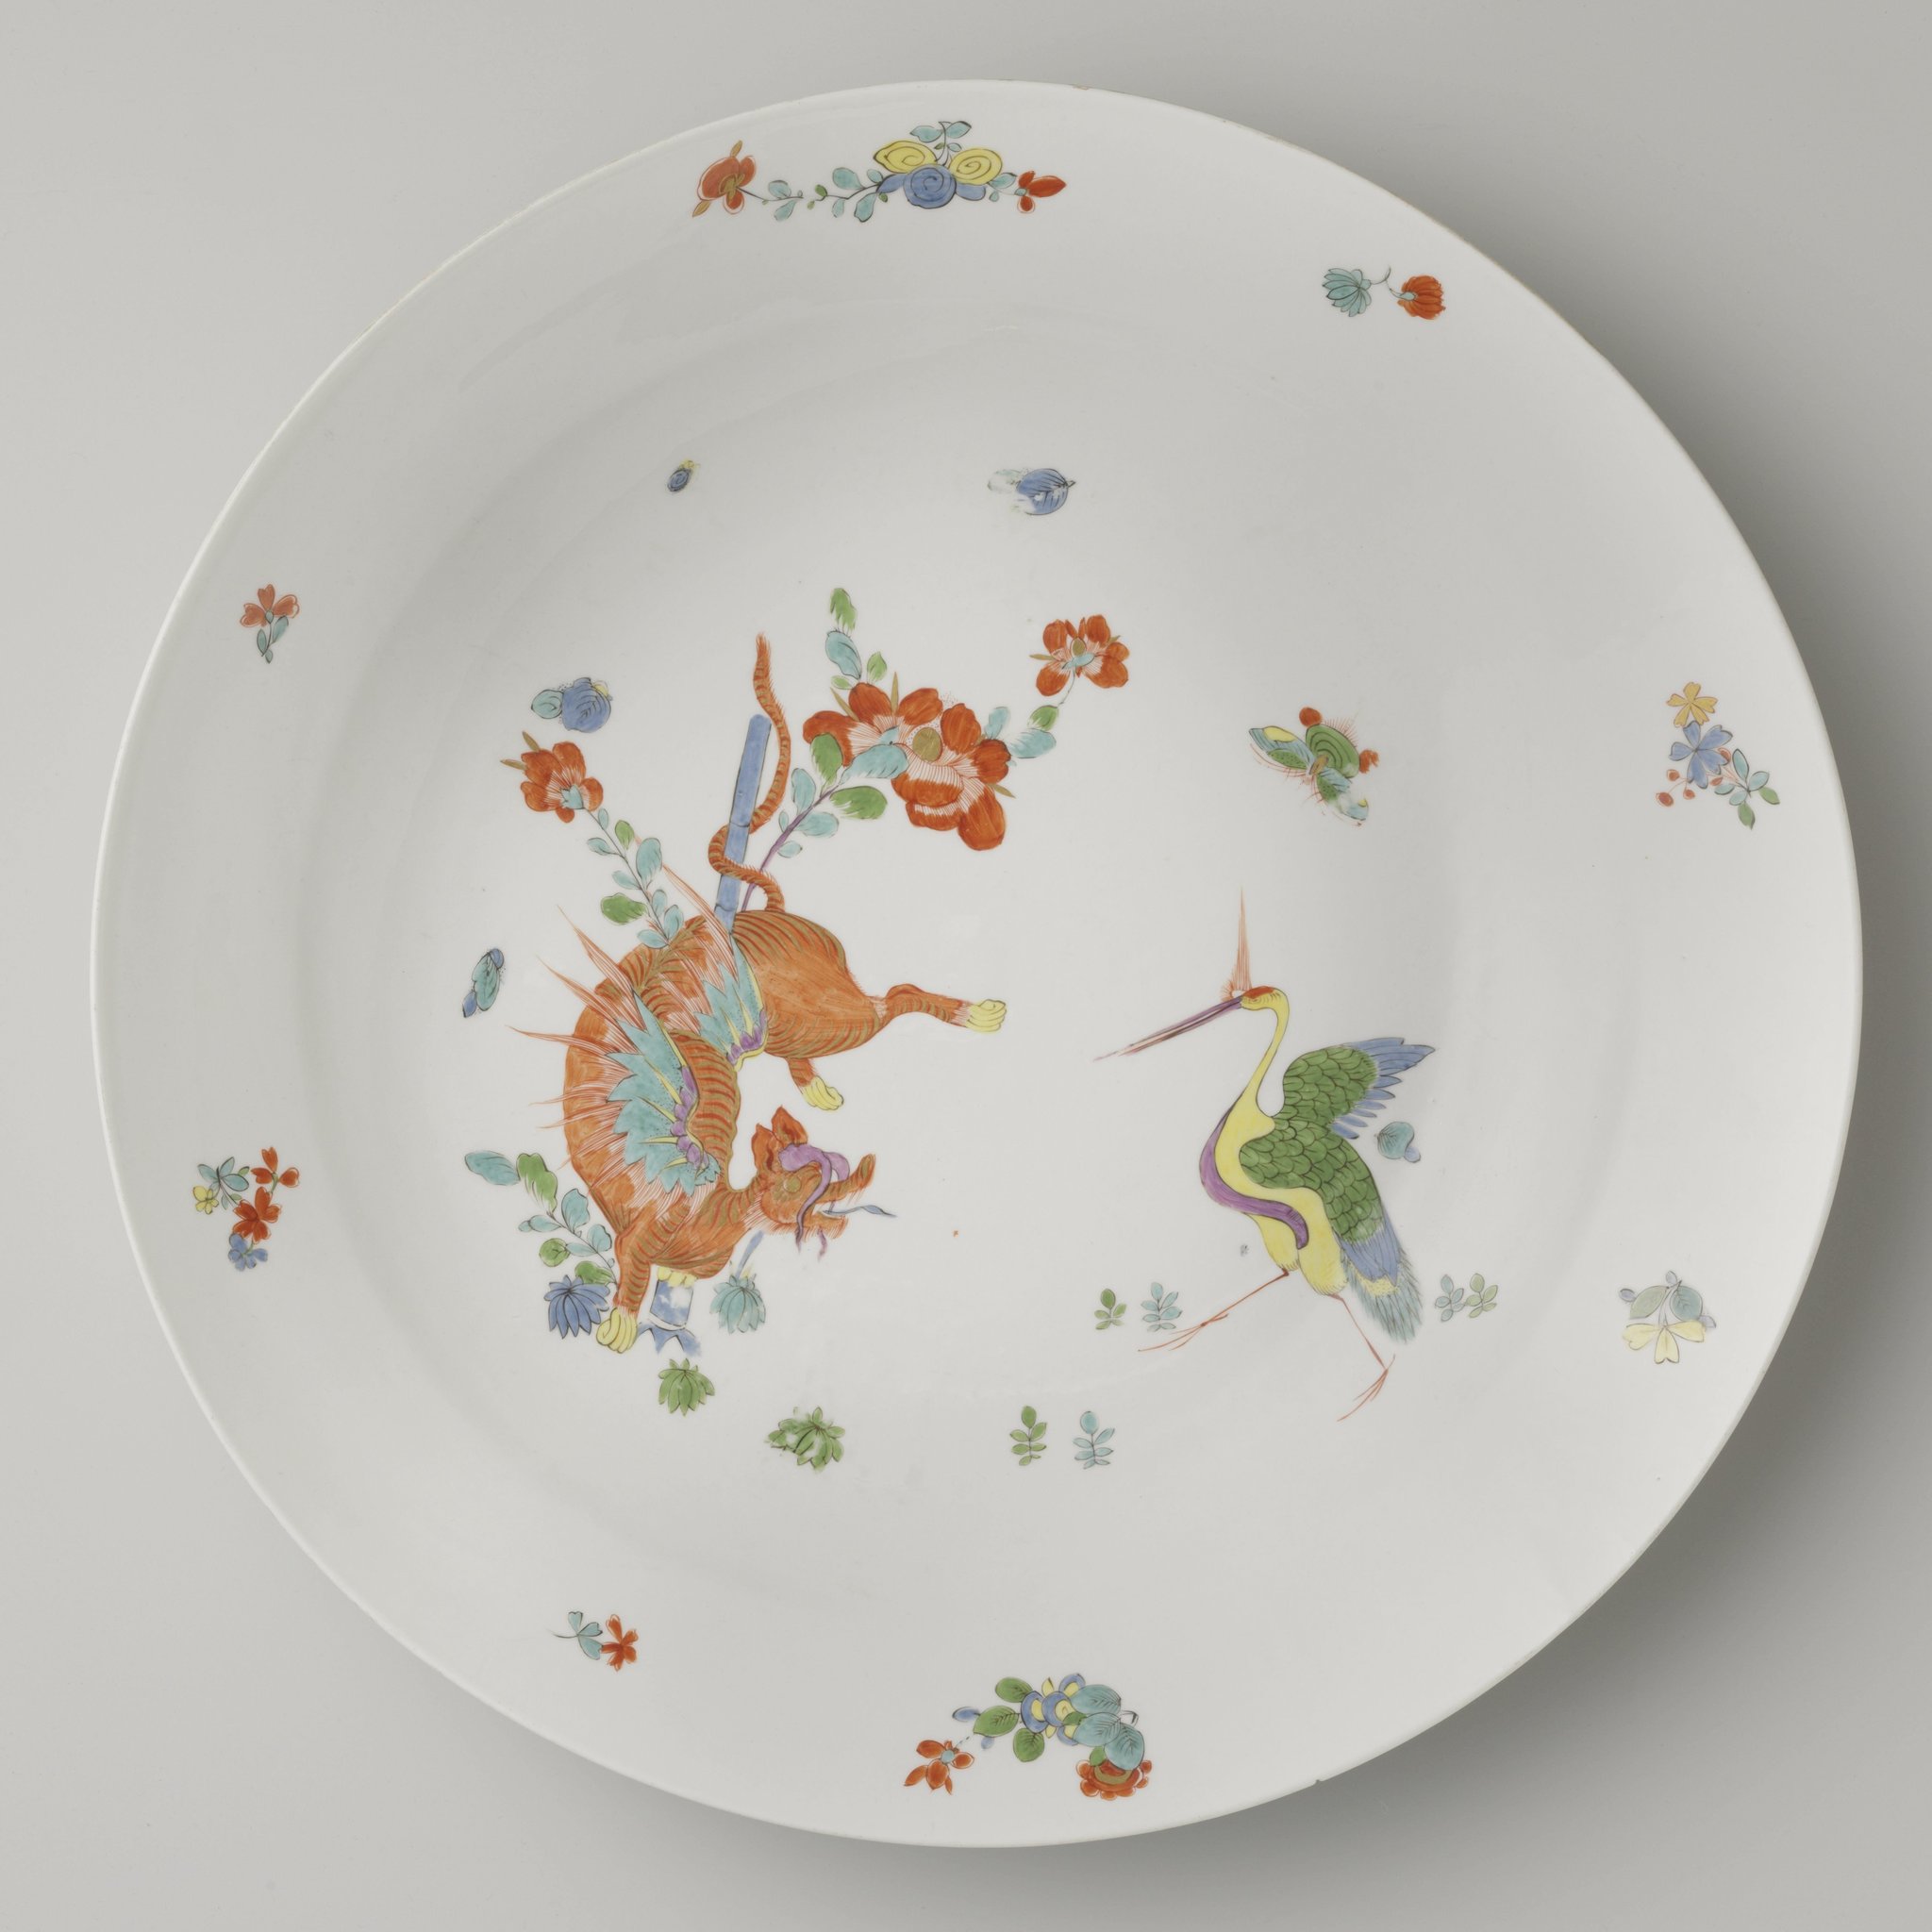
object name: eating drinking utensil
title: Schotel, veelkleurig beschilderd met een Kakiemon-decor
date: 1730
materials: porcelain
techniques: painted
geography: meissen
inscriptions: mold mark, mark: ‘V’, factory mark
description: Plate. Meissen, c. 1725 - 1735.